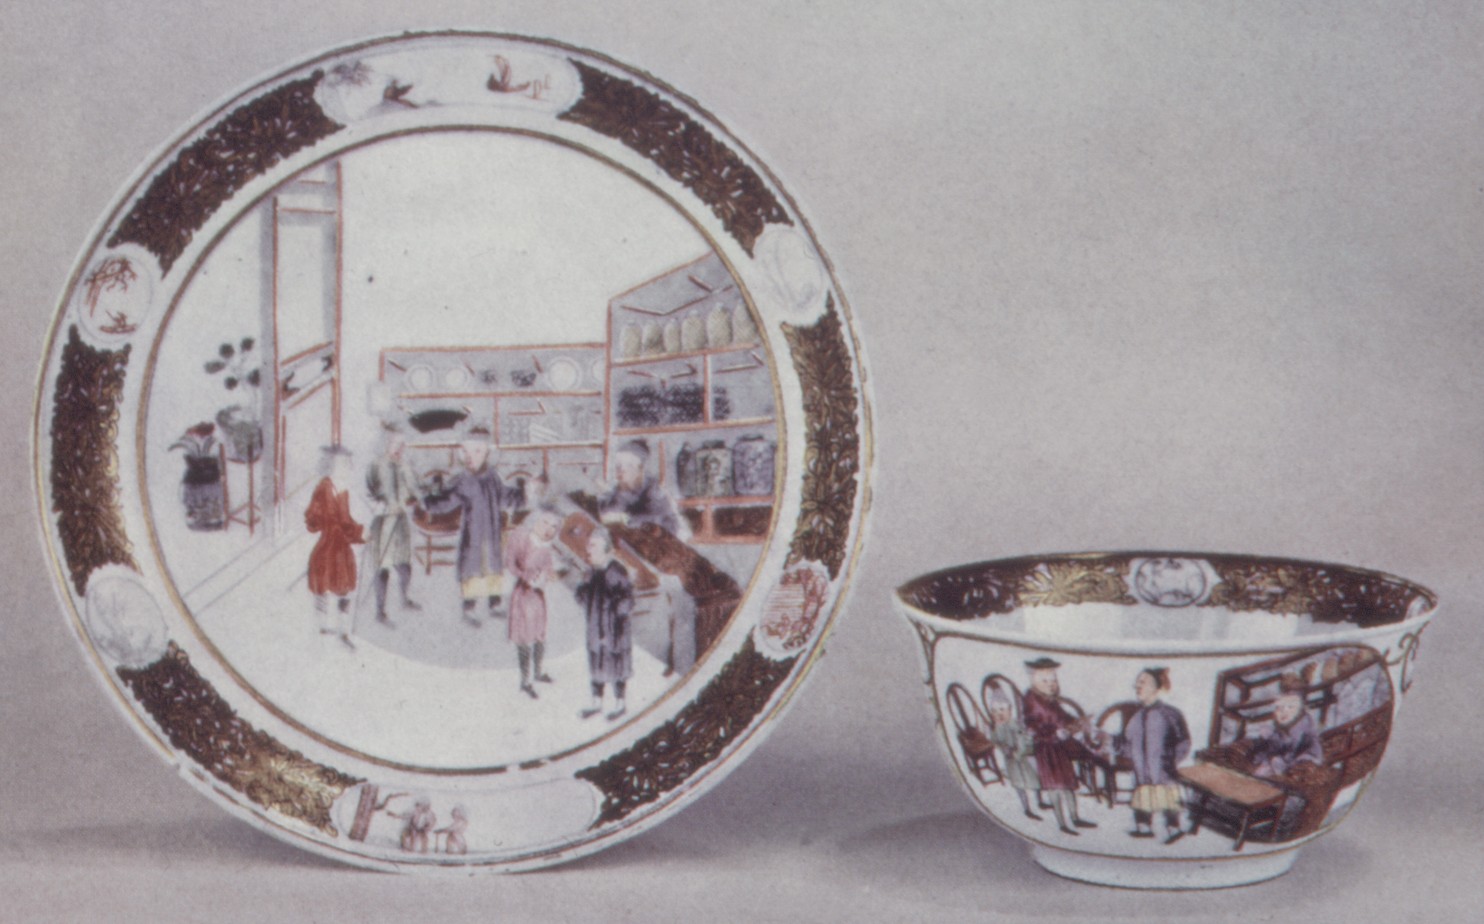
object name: cup and saucer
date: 1725-1740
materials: hard paste porcelain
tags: men